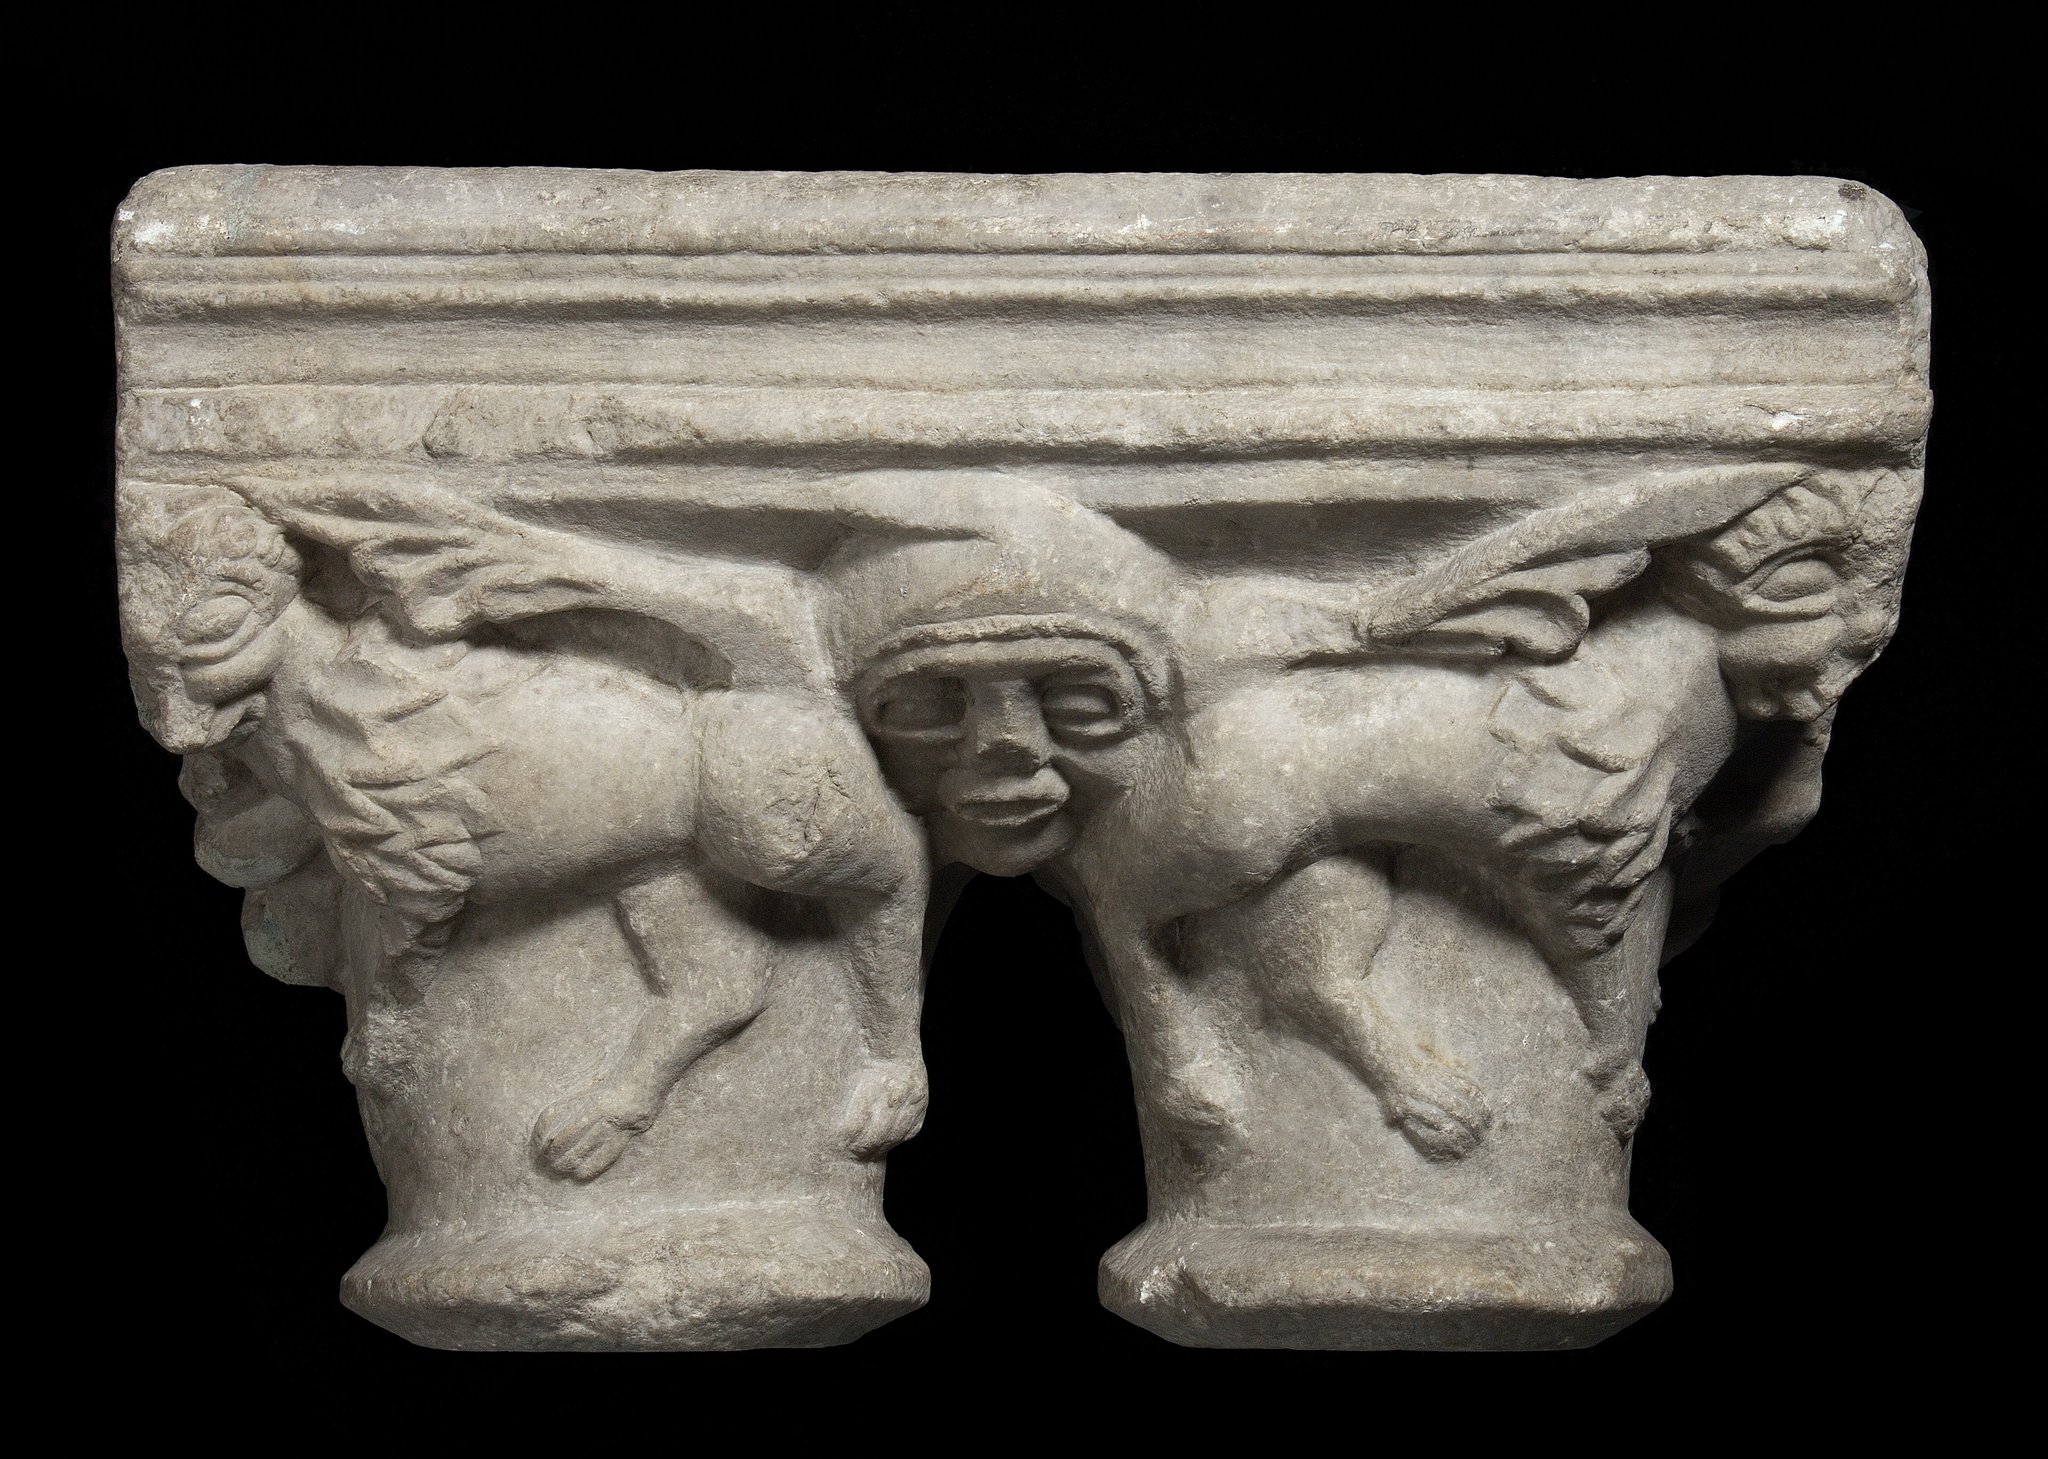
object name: capital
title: Double Capital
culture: french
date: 1267-1333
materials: marble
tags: faces,lions